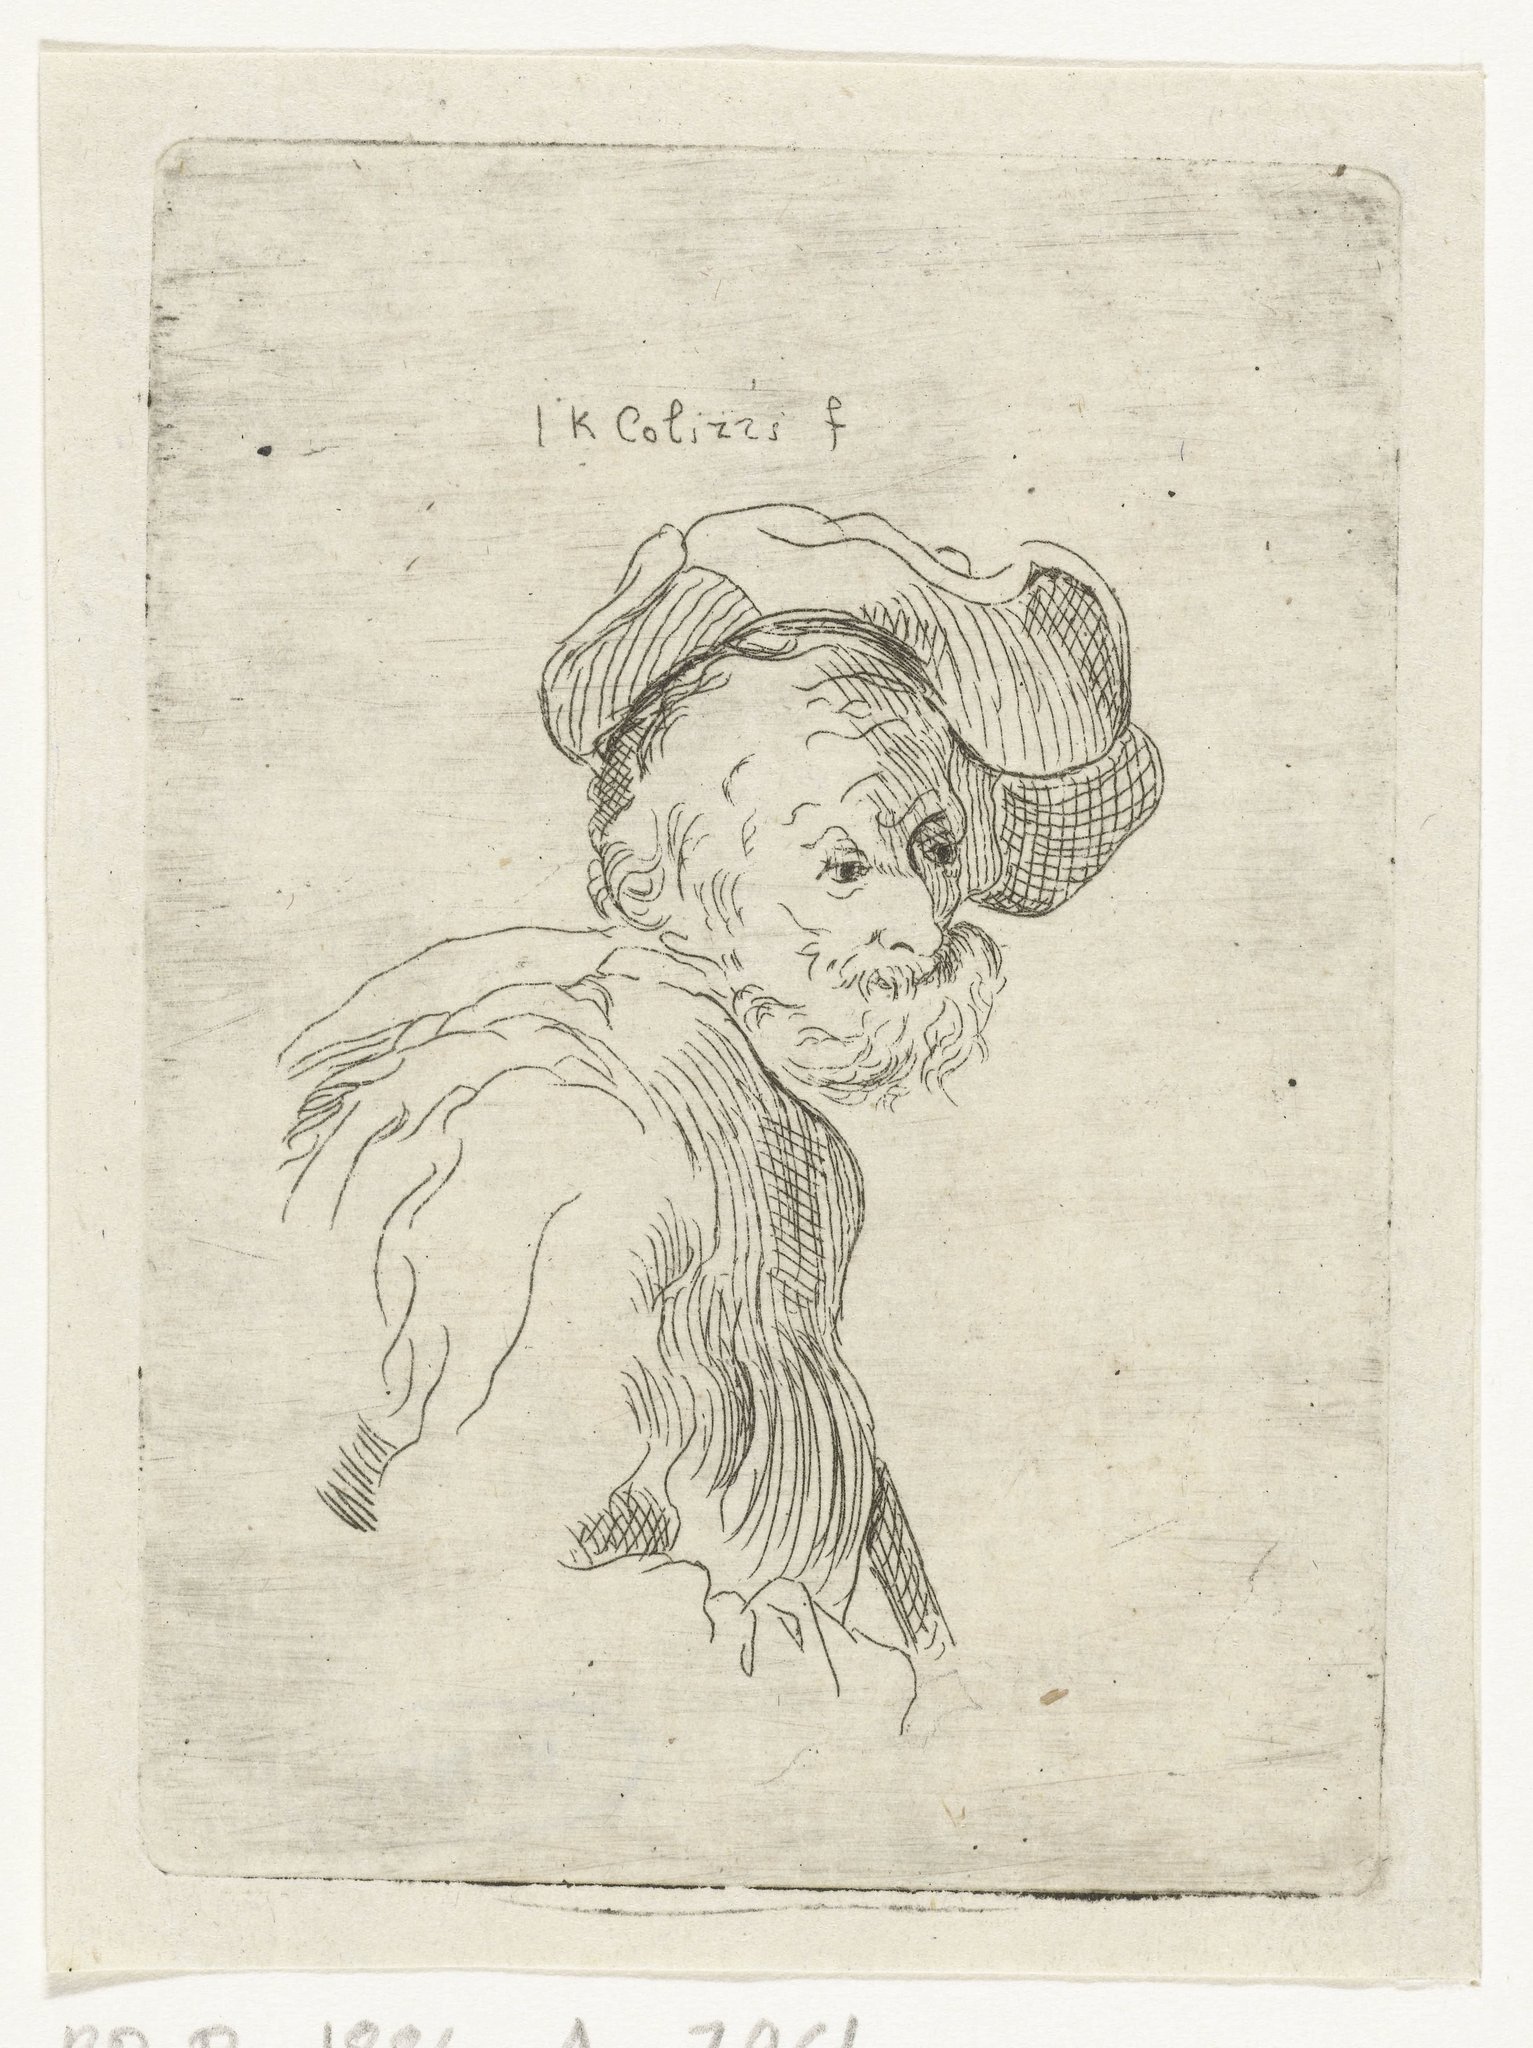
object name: print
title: Portret van een man met baret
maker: johan antoni kauclitz colizzi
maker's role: print maker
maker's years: 1742-1808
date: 1774-1808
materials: paper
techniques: etching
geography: amsterdam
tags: anonymous historical person portrayed alone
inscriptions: collector's mark: Lugt 2228